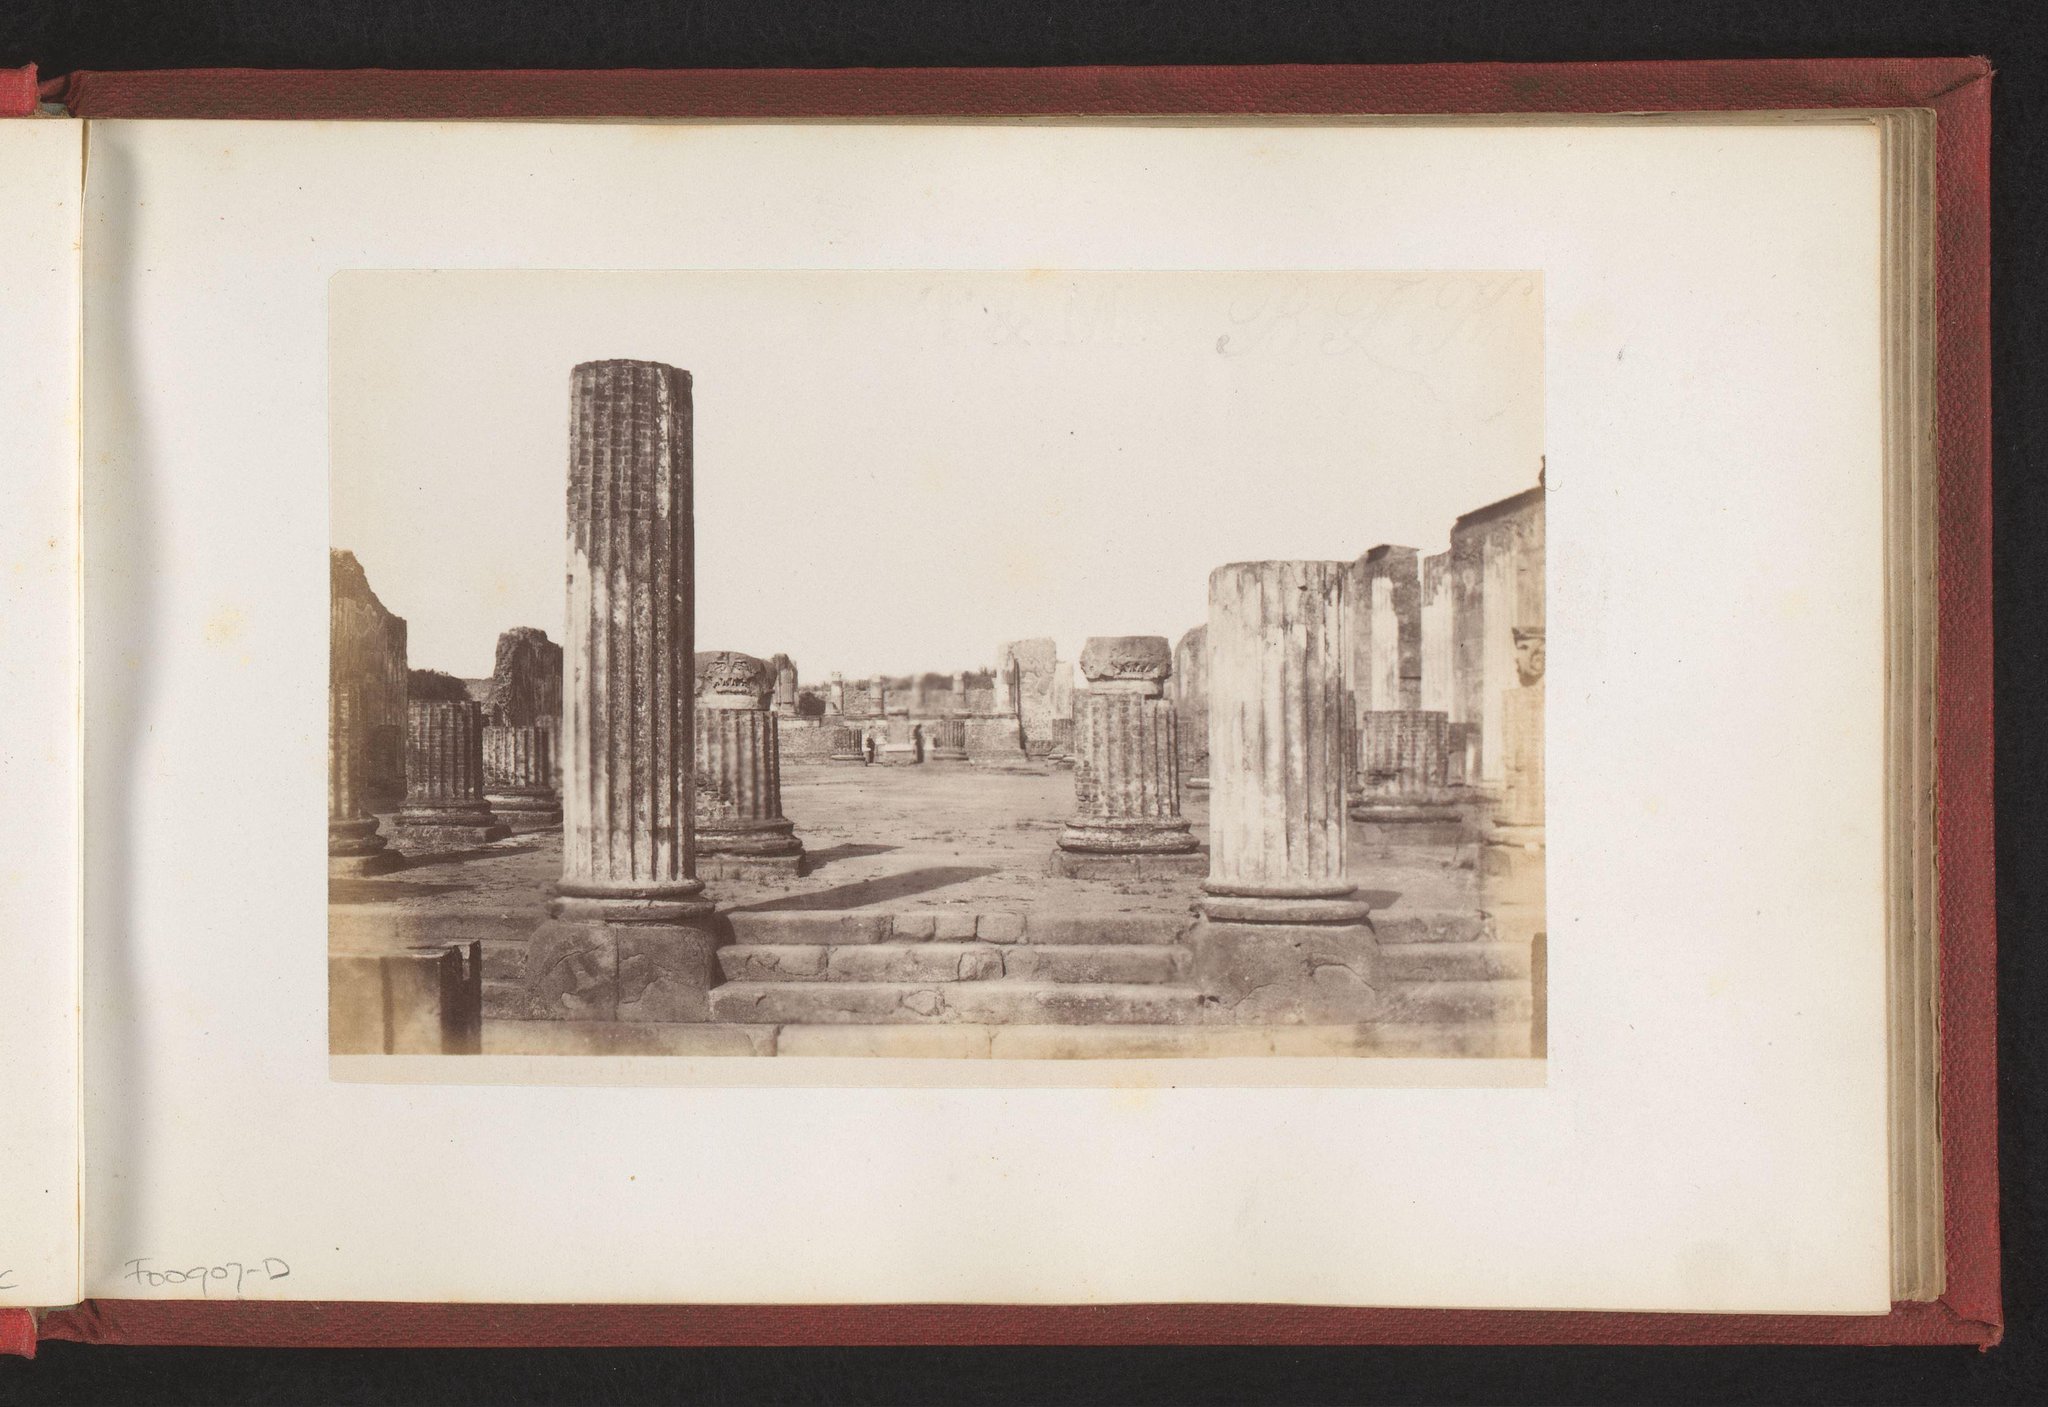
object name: photograph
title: Ruïne van de Basilica te Pompeï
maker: Anonymous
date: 1860-1900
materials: photographic support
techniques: albumen print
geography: pompeii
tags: column, pillar ~ architecture, ruin of a building ~ architecture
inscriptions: inscription: ‘T&M B.[...].K.’